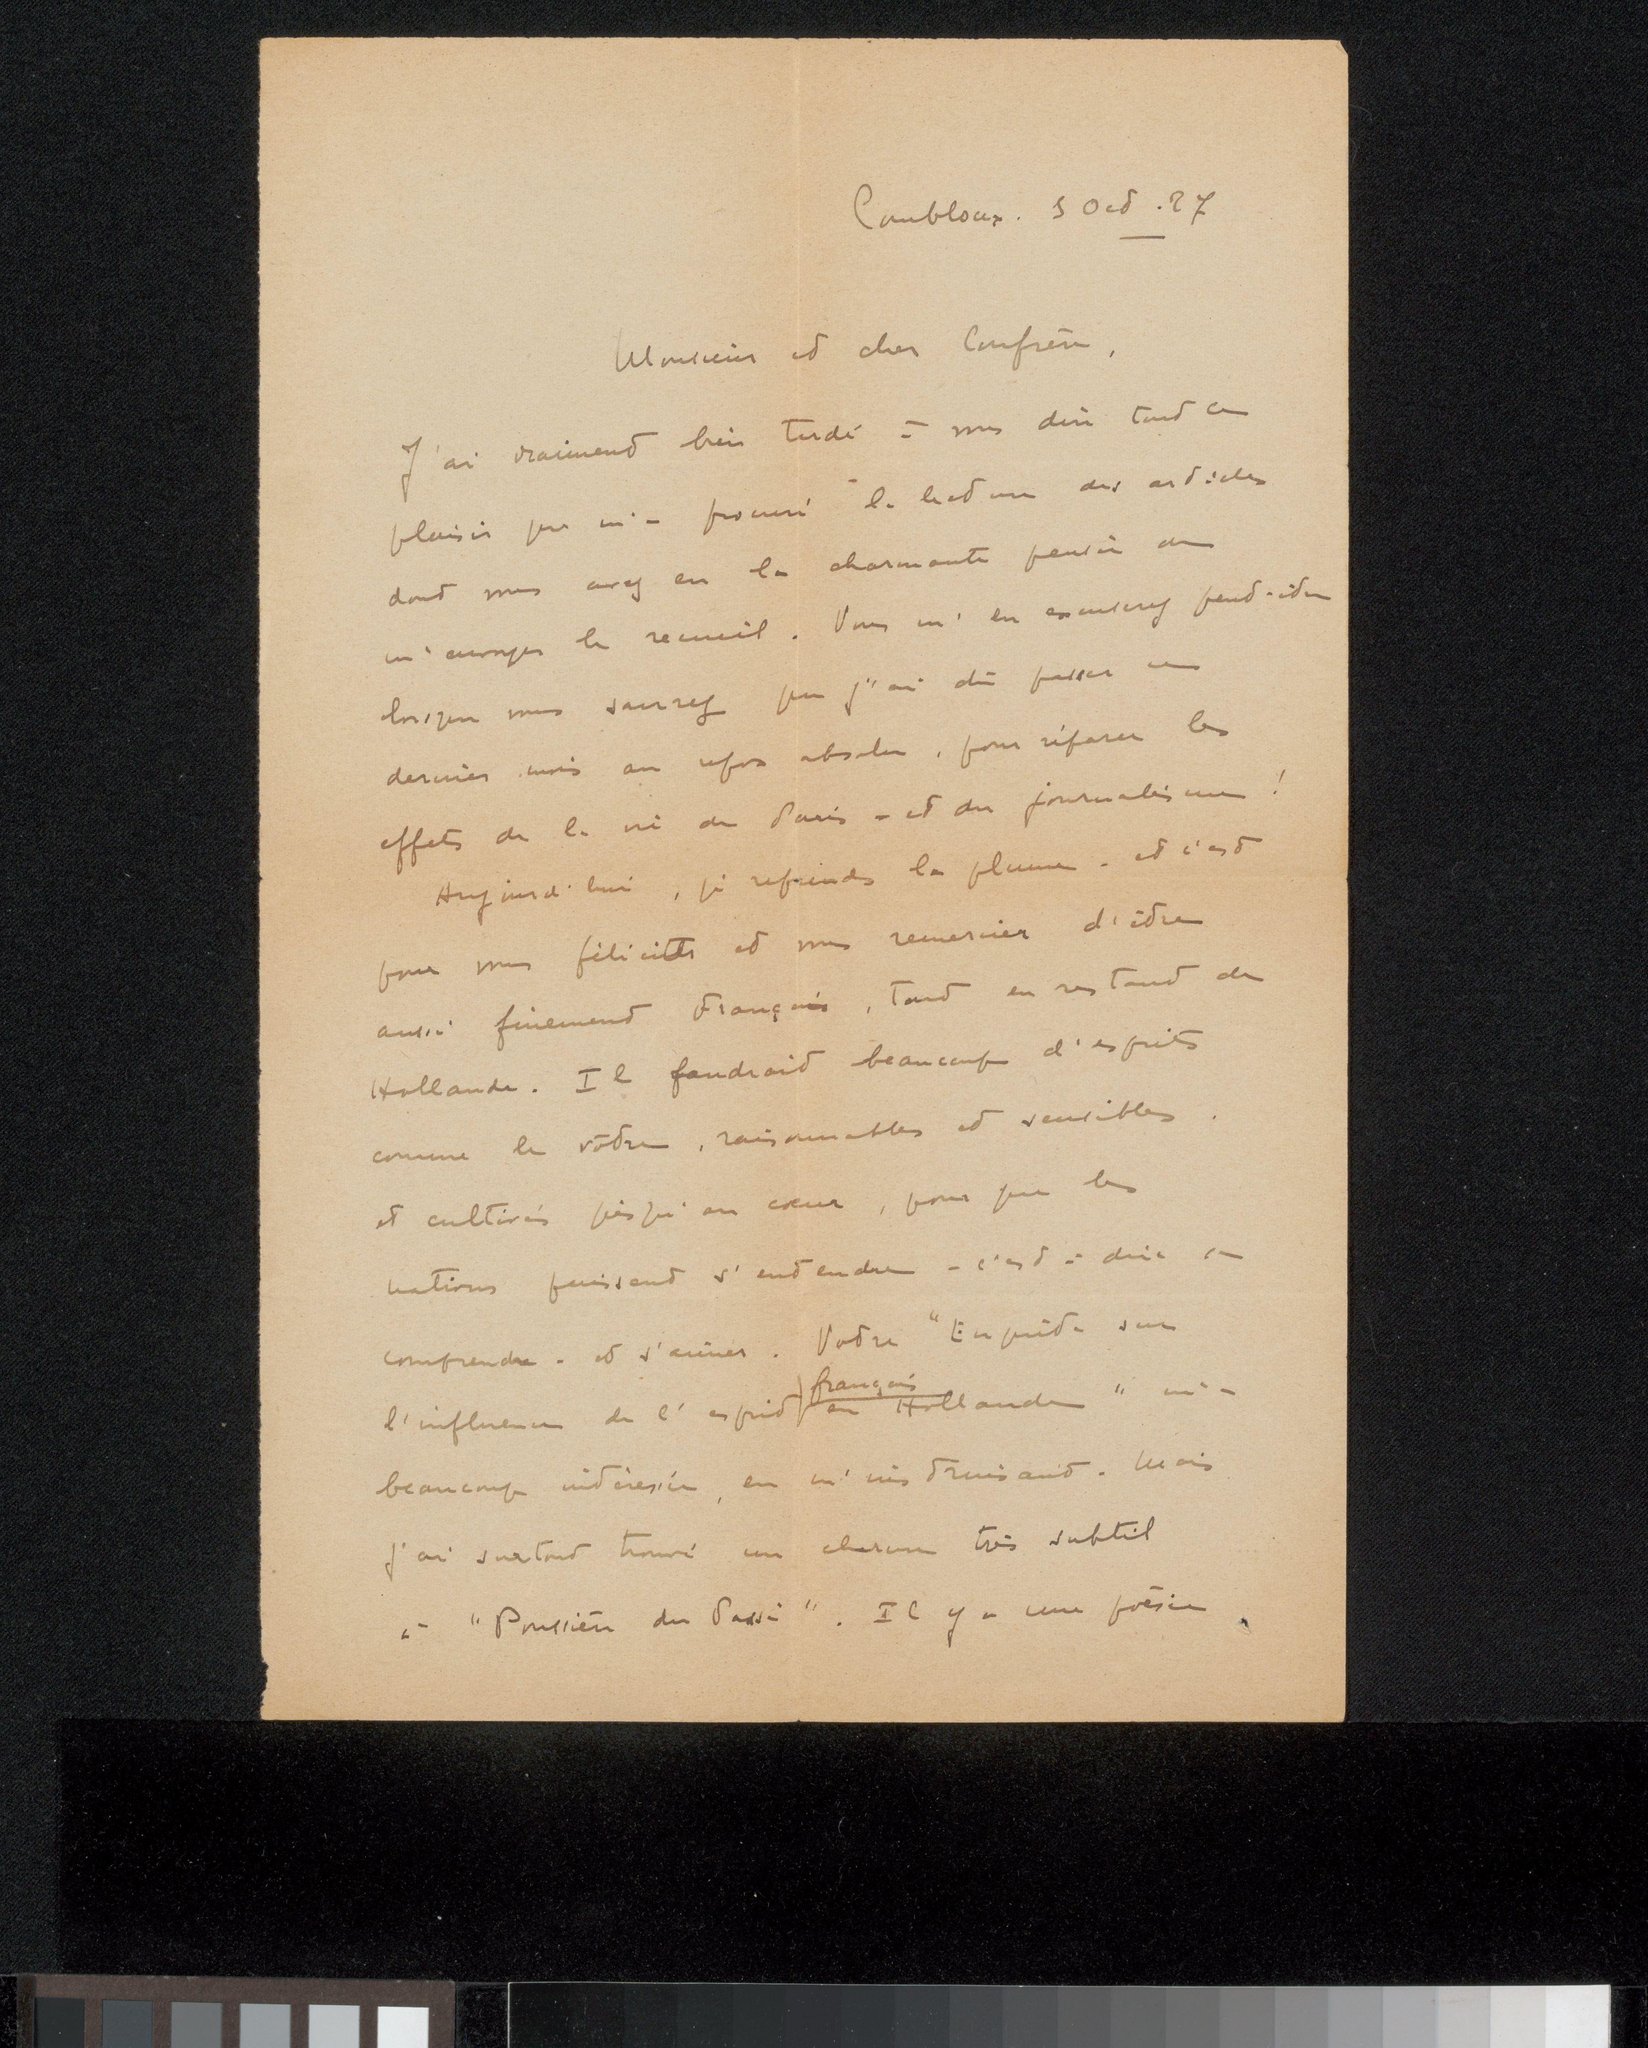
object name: letter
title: Brief aan Philip Zilcken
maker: simonne ratel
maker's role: schrijver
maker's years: 1900-1948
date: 1927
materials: ink, paper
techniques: pen, writing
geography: combloux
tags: the hague, painter, draughtsman, philip zilcken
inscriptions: collector's mark: ‘RPK’